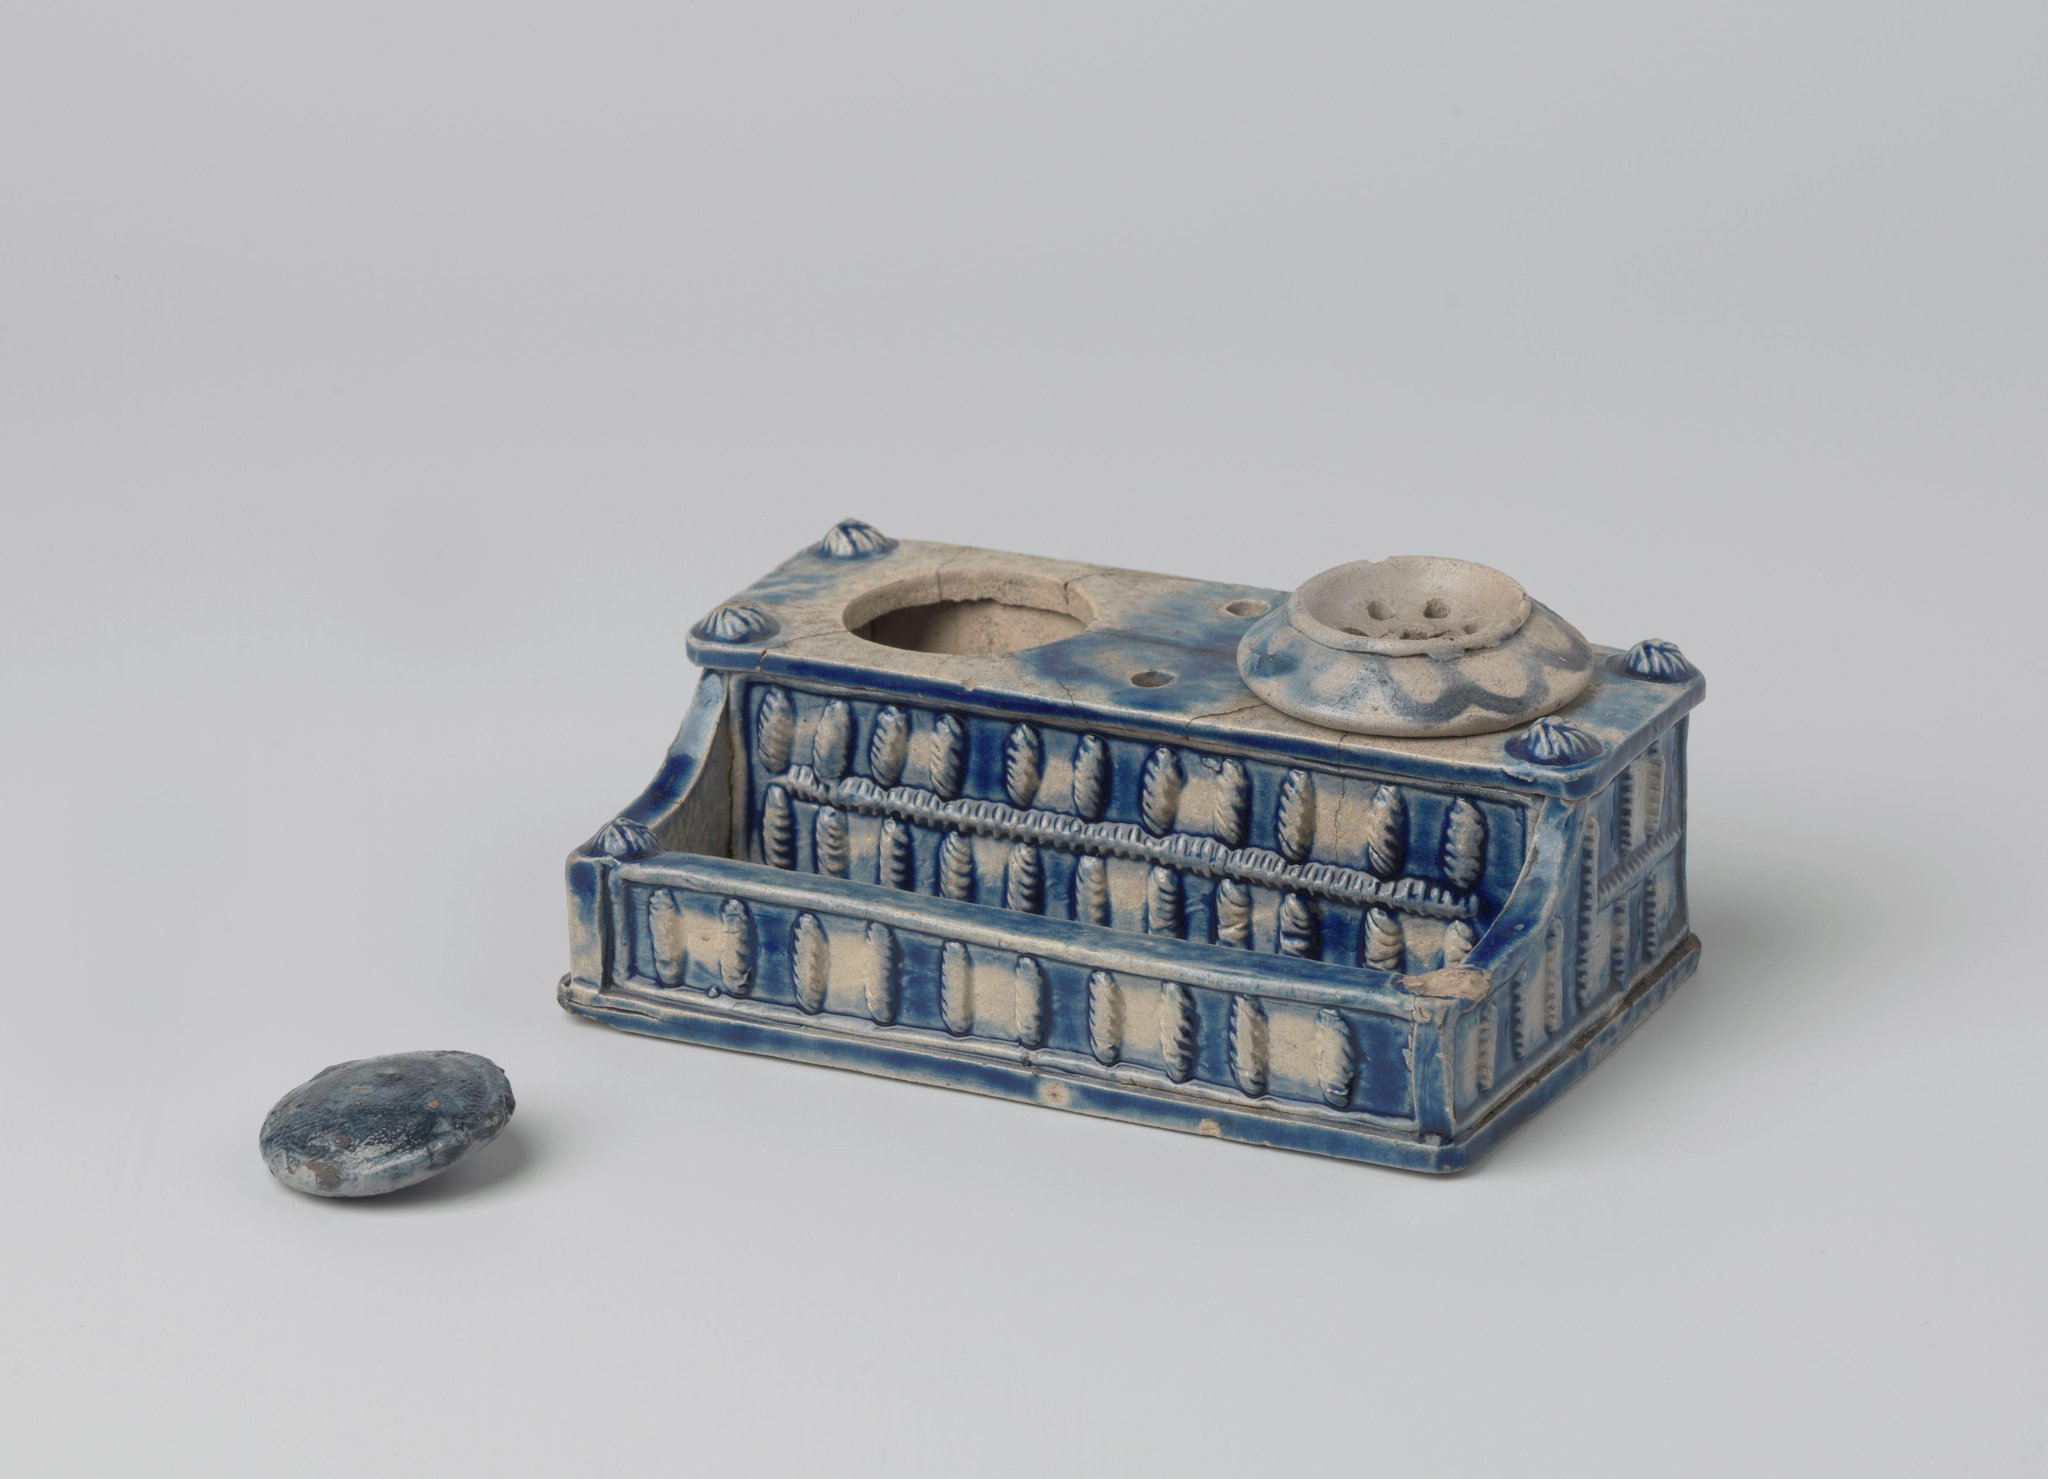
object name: lid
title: Cover of an ink well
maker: Anonymous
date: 1750-1799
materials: cobalt, glaze, stoneware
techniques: firing, turning, vitrification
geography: westerwald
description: Deksel van steengoed, de inktpot ontbreekt. Bedekt met kobaltblauw. Westerwald.